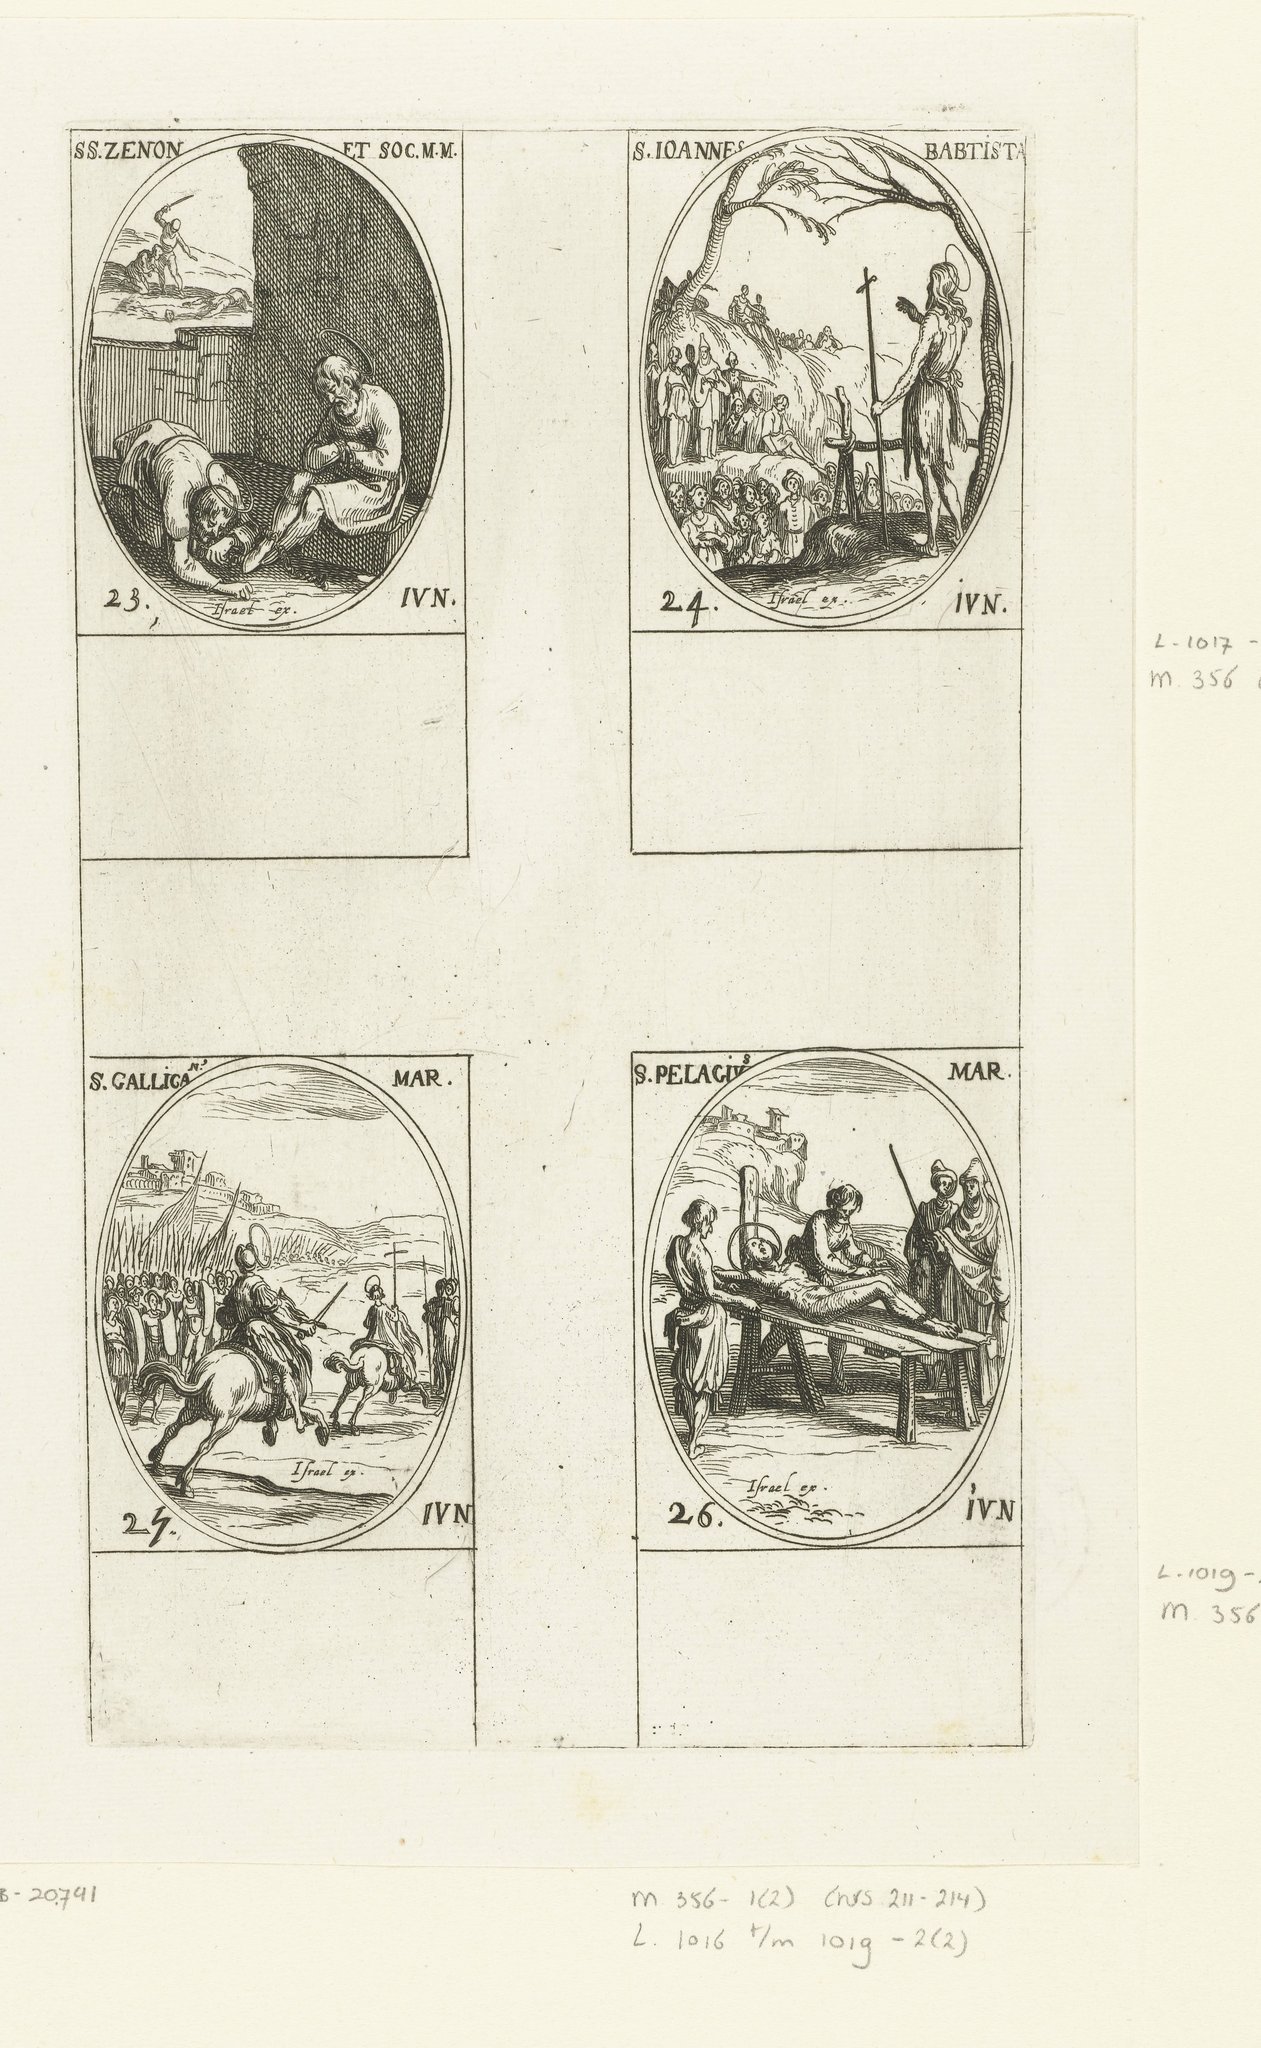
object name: print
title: Alle heiligen en de Christelijke feestdagen van het jaar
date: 1632-1636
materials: paper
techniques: etching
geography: nancy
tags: john the baptist; possible attributes: book, reed cross, baptismal cup, honeycomb, lamb, staff, male saints (with name), john the baptist preaching (perhaps christ among the bystanders)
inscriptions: collector's mark: Lugt 240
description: Blad met vier ovale voorstellingen, elk met opschrift en datum in het Latijn: linksboven de Heilige Zeno en een andere heilige in een gevangenis, rechtsboven Johannes de Doper die preekt tot een menigte, linksonder de Heilige Gallicanus als legerleider te paard, rechtsonder de Heilige Pelagius van Cordoba op een pijnbank. Deze prent is onderdeel van een serie prenten met voorstellingen van de heiligen en de christelijke feestdagen van het jaar. Er zijn steeds vier scènes van één plaat op één blad gedrukt. Inclusief bijbehorend titelblad en frontispice gaat het in totaal om 124 platen (490 voorstellingen). De drie platen met de laatste 12 scènes (de veranderlijke christelijke feestdagen) zijn in de derde staat versneden tot 12 kleine plaatjes, en met een apart titelblad uitgegeven.